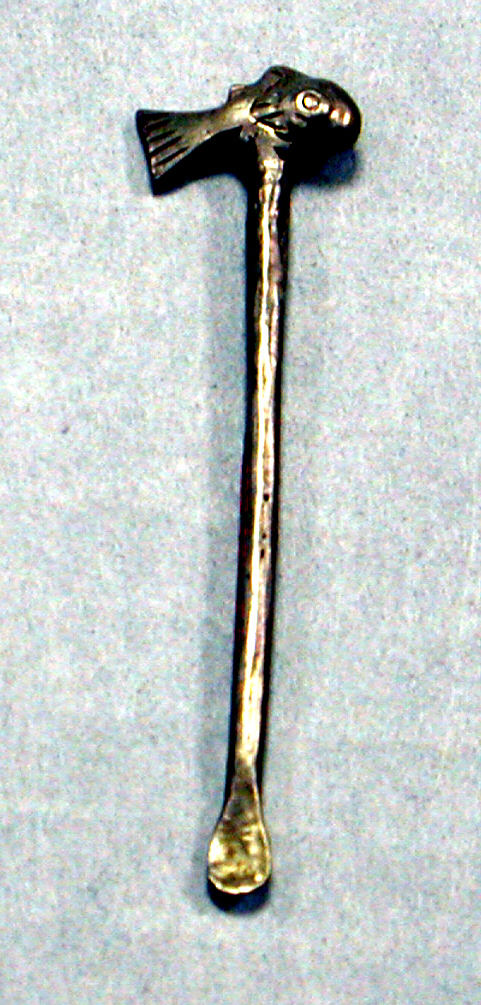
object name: lime spoon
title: Silver Lime Spoon with Fish Top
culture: inca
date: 1401-1600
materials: silver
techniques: casting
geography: peru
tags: fish